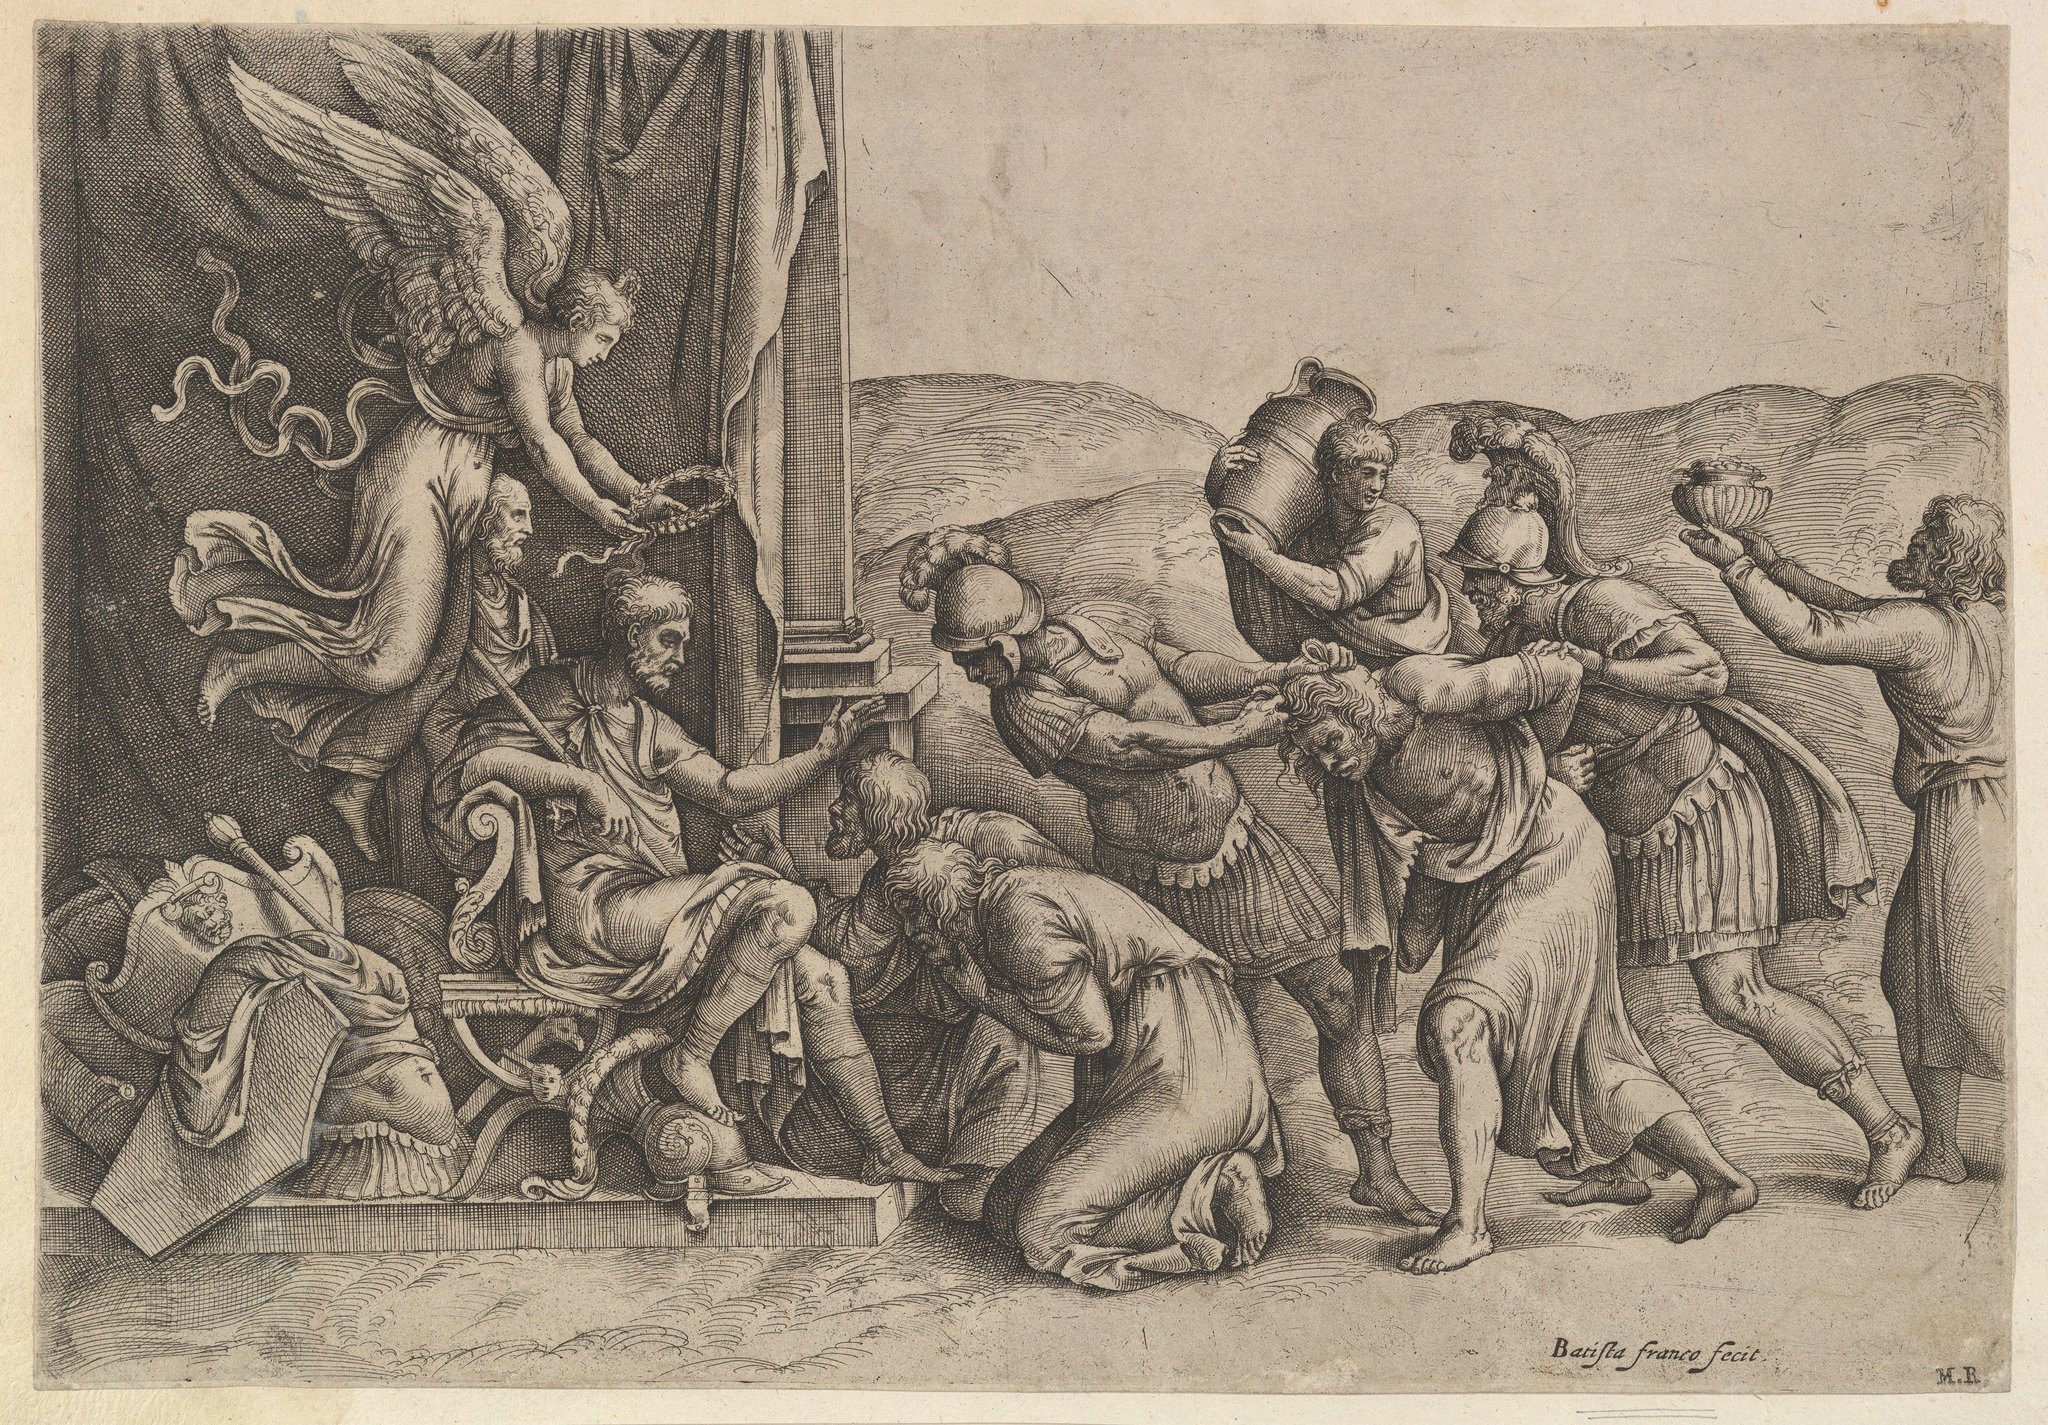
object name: print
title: Scipio Granting Clemency to the Prisoners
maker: battista franco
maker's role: artist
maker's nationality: italian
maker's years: 1510-1561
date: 1530-1561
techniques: engraving, etching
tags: soldiers,prisoners,men